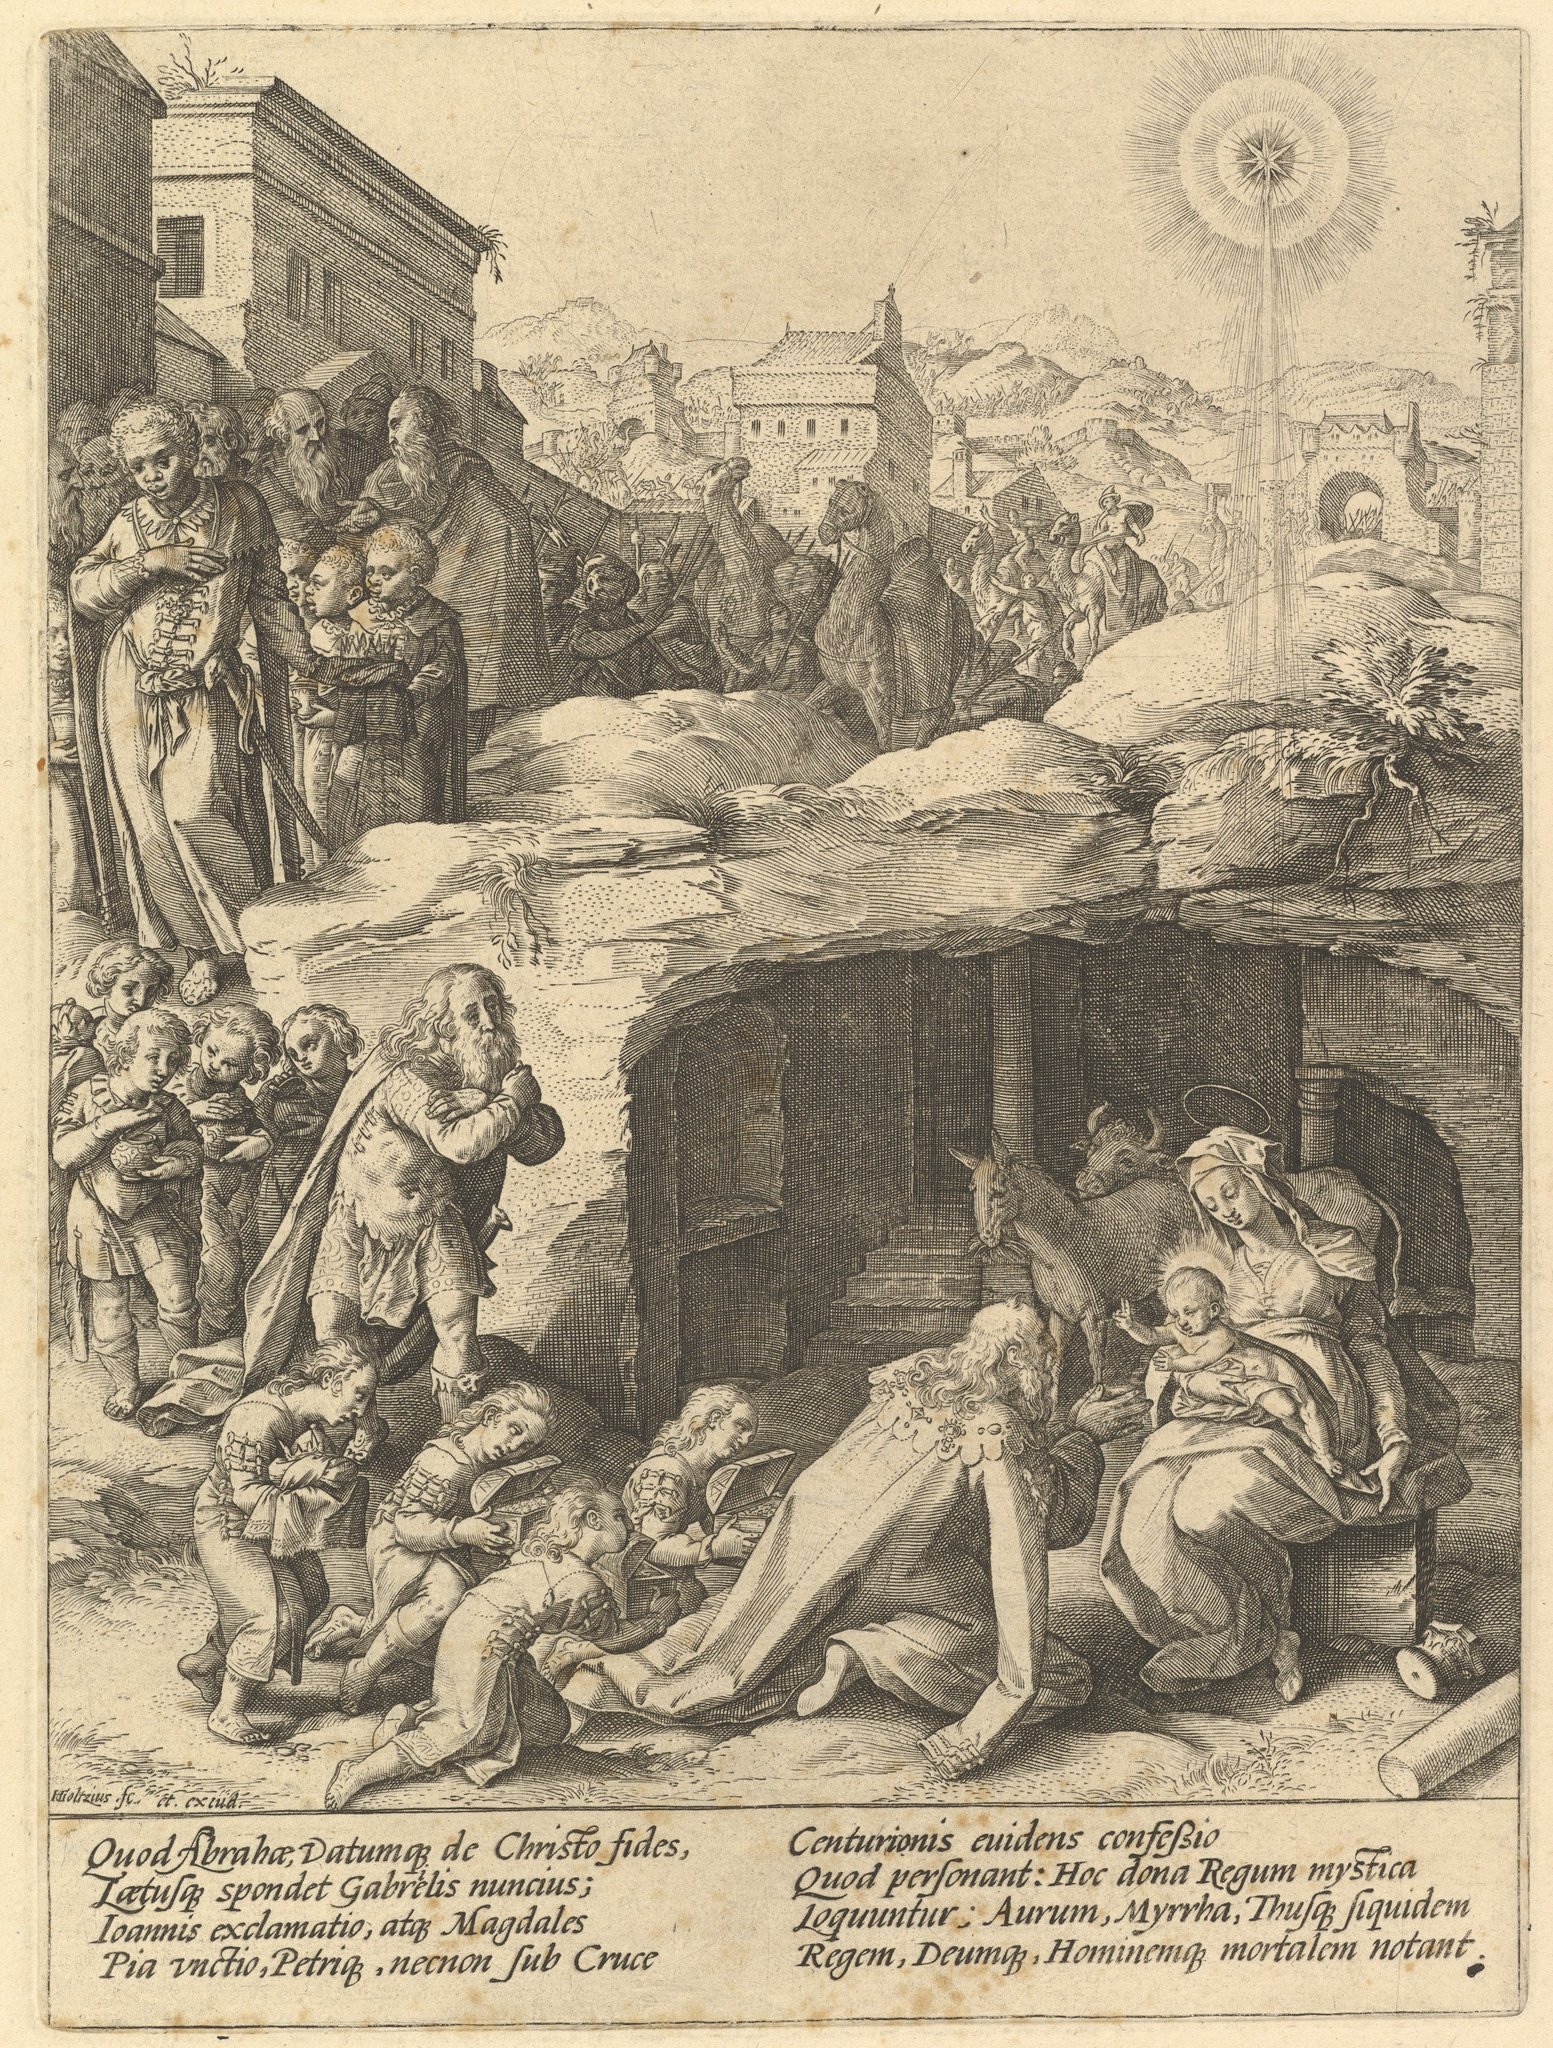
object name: print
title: The Adoration of the Magi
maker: hendrick goltzius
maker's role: artist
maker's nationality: netherlandish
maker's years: 1558-1617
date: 1585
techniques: engraving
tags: boys,girls,men,madonna and child,adoration of the magi